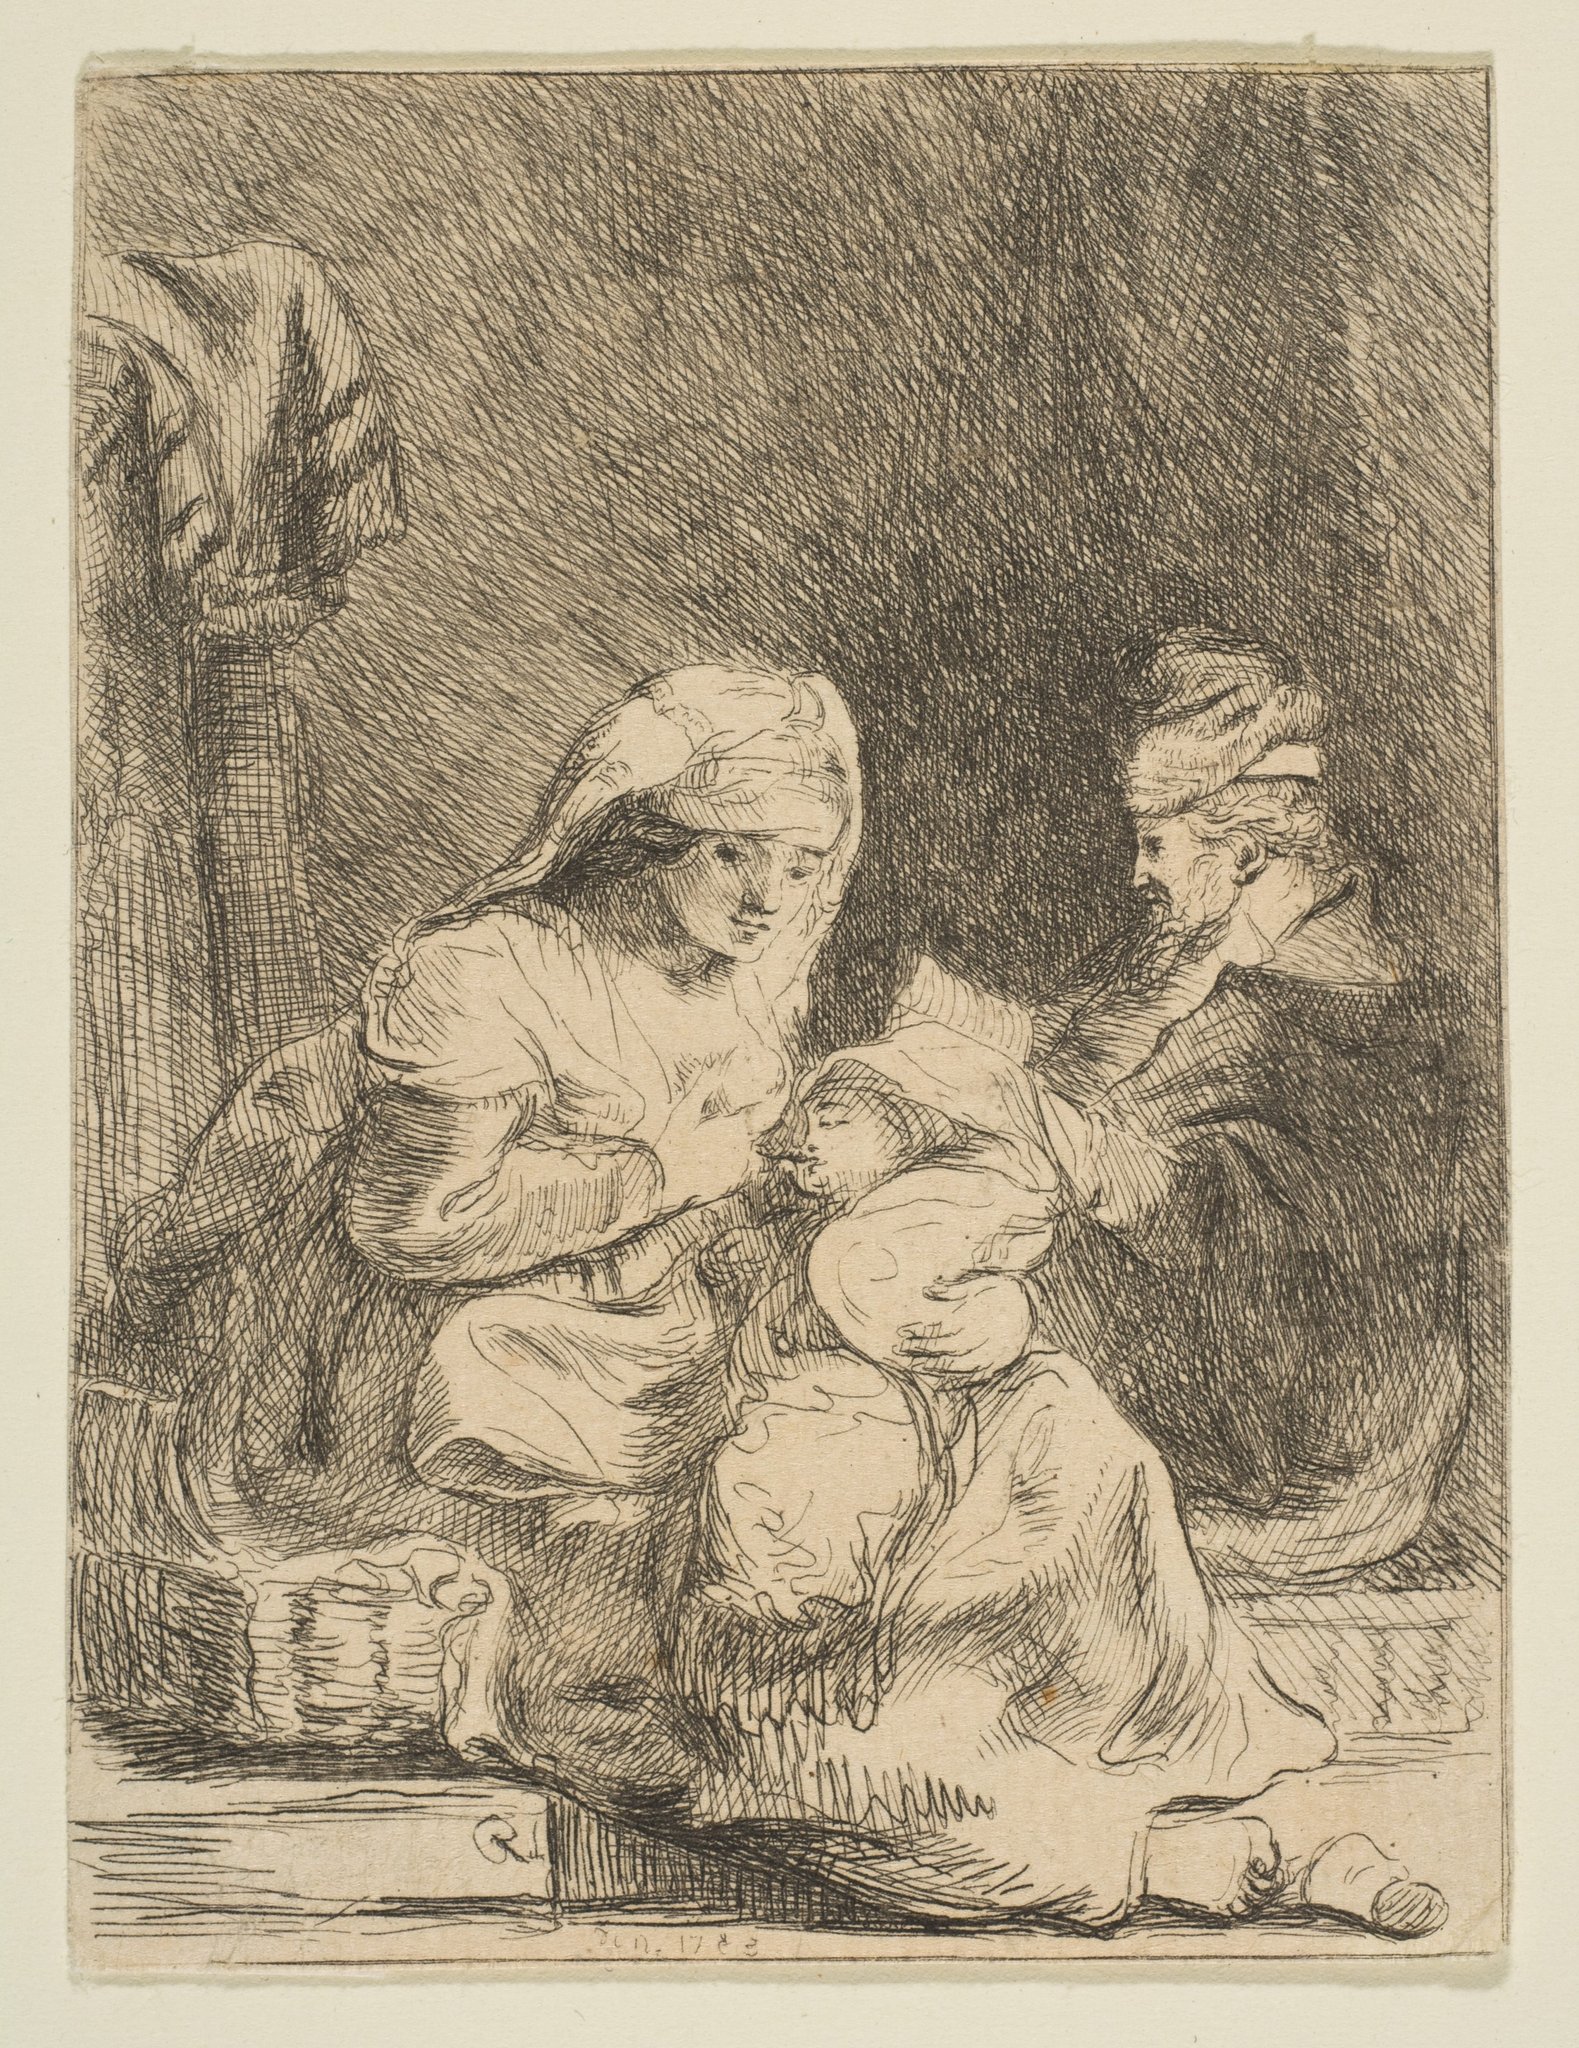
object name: print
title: The Holy Family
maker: baron dominique vivant denon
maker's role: artist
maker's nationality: french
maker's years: 1747-1825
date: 1783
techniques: etching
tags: christ,holy family,saint joseph,virgin mary